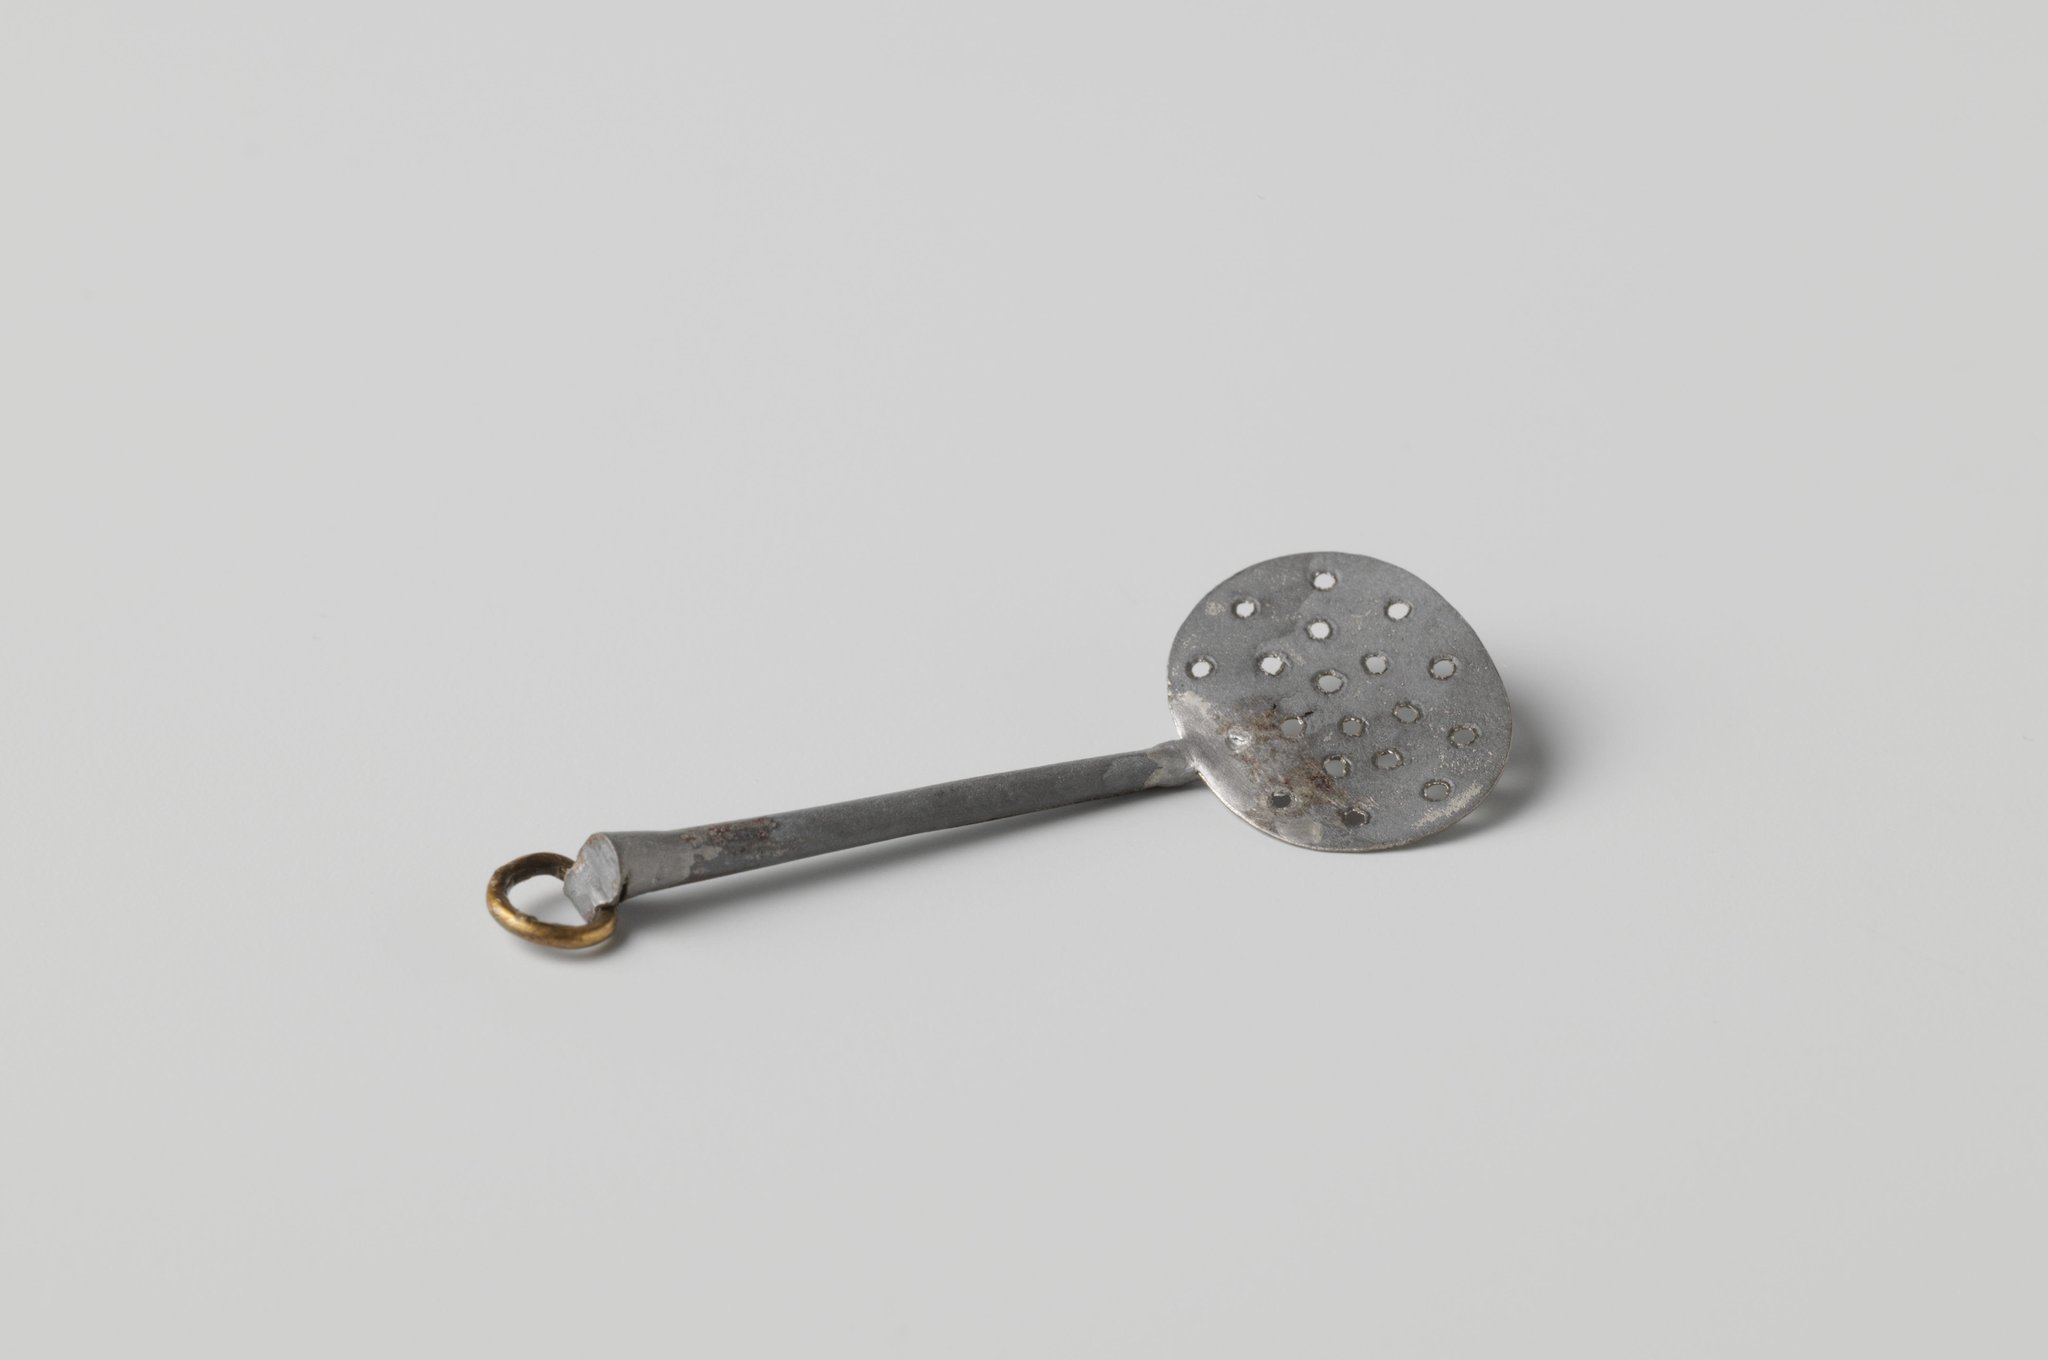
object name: skimmer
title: Schuimspaan met ovaal blad en steel met ring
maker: Anonymous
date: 1700-1799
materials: copper, metal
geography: amsterdam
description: Schuimspaan met ovaal blad en steel van blok, eindigend in een koperen ring.